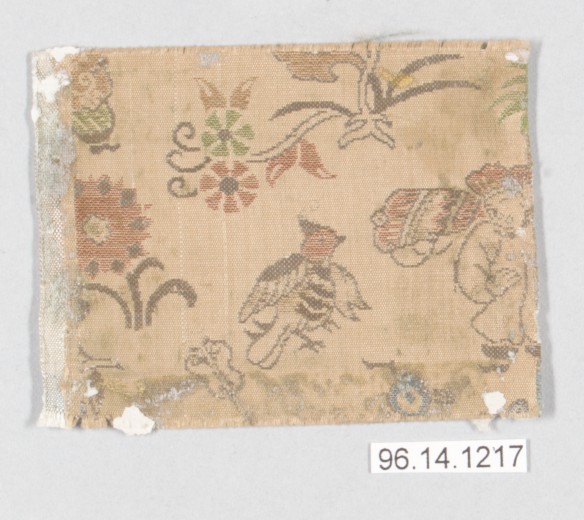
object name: piece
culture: japanese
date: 1701-1900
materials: silk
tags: birds,men